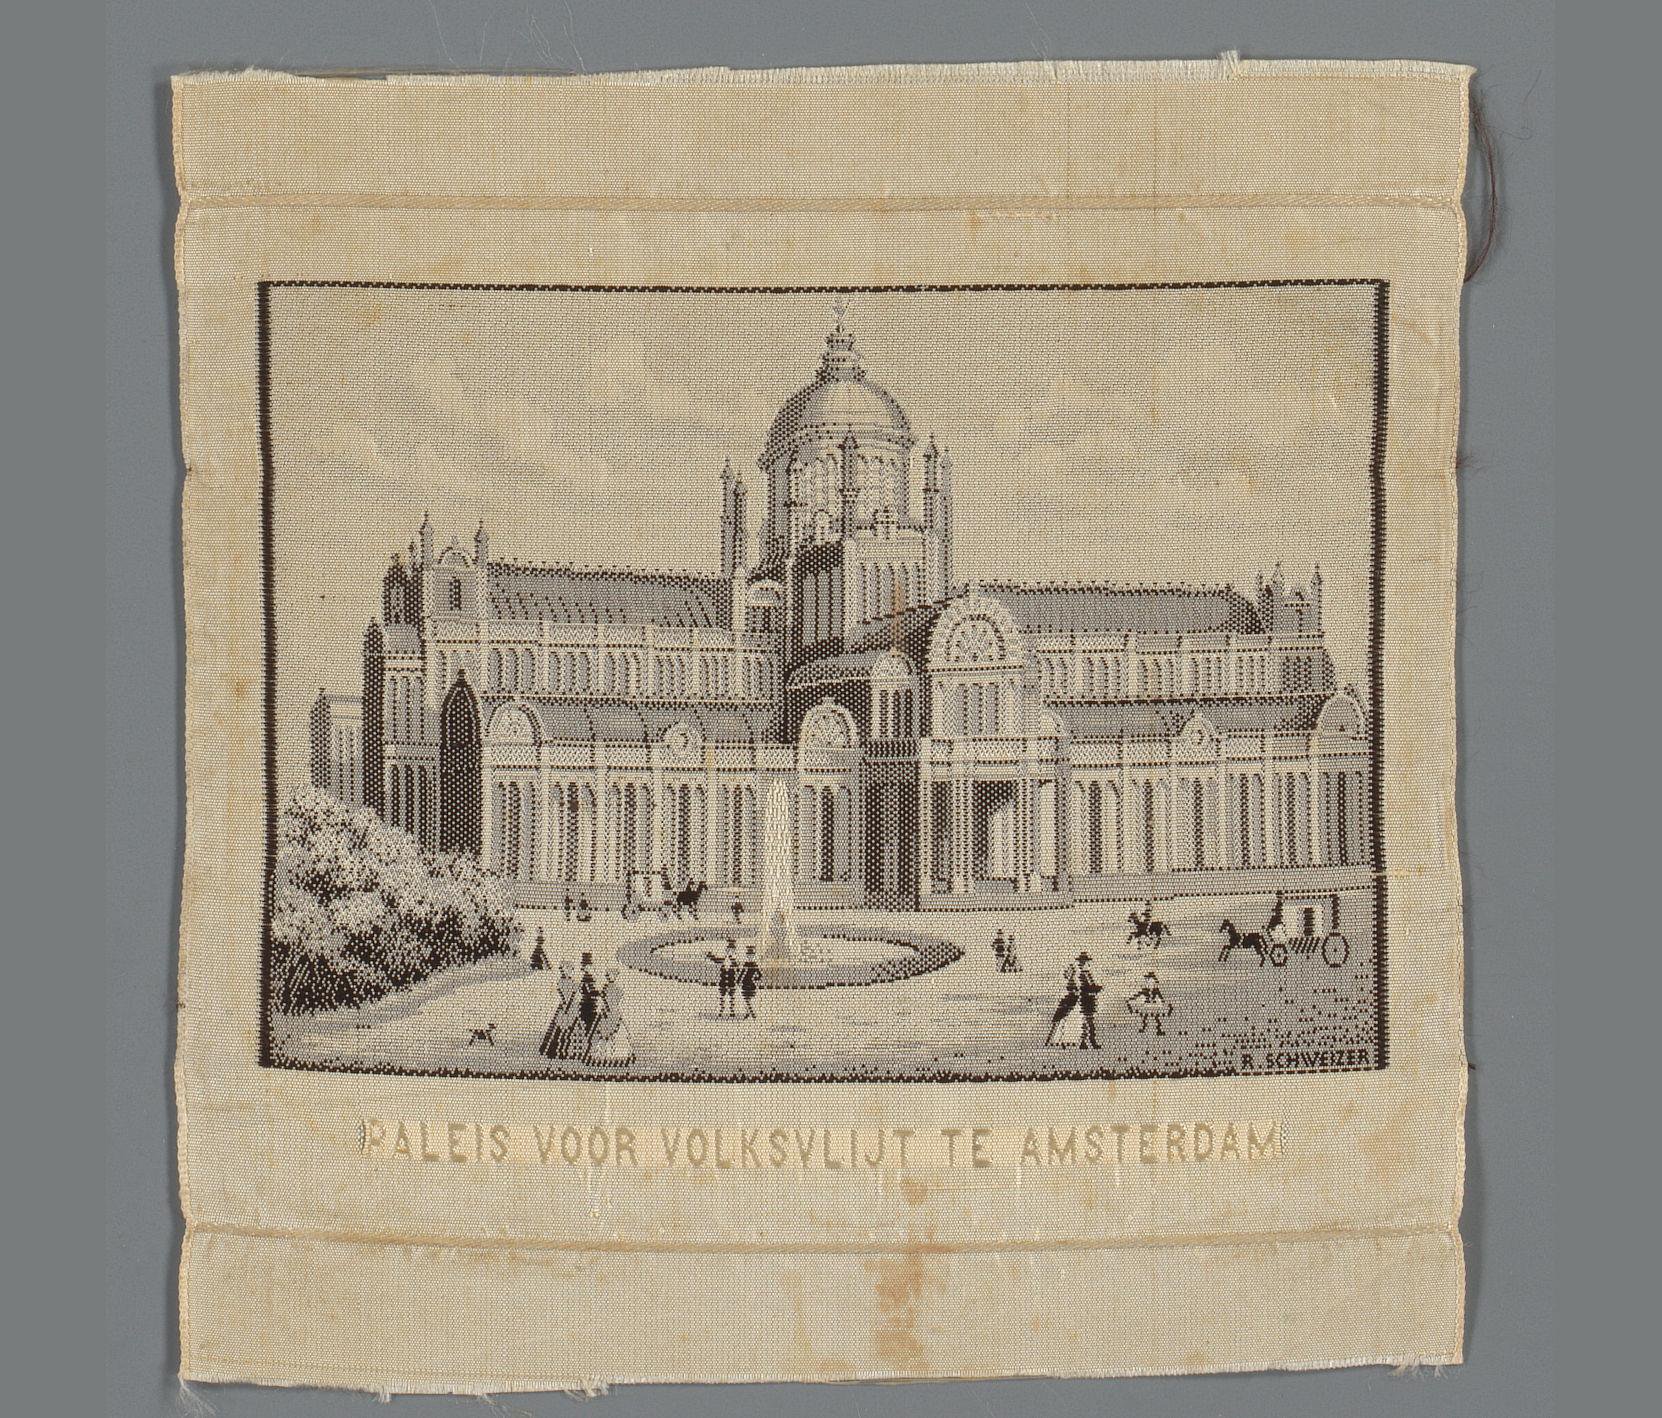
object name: woven material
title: Gezicht op het Paleis voor Volksvlijt te Amsterdam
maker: r. schweizer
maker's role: wever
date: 1864-1900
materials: textile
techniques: weave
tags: exterior ~ representation of a building